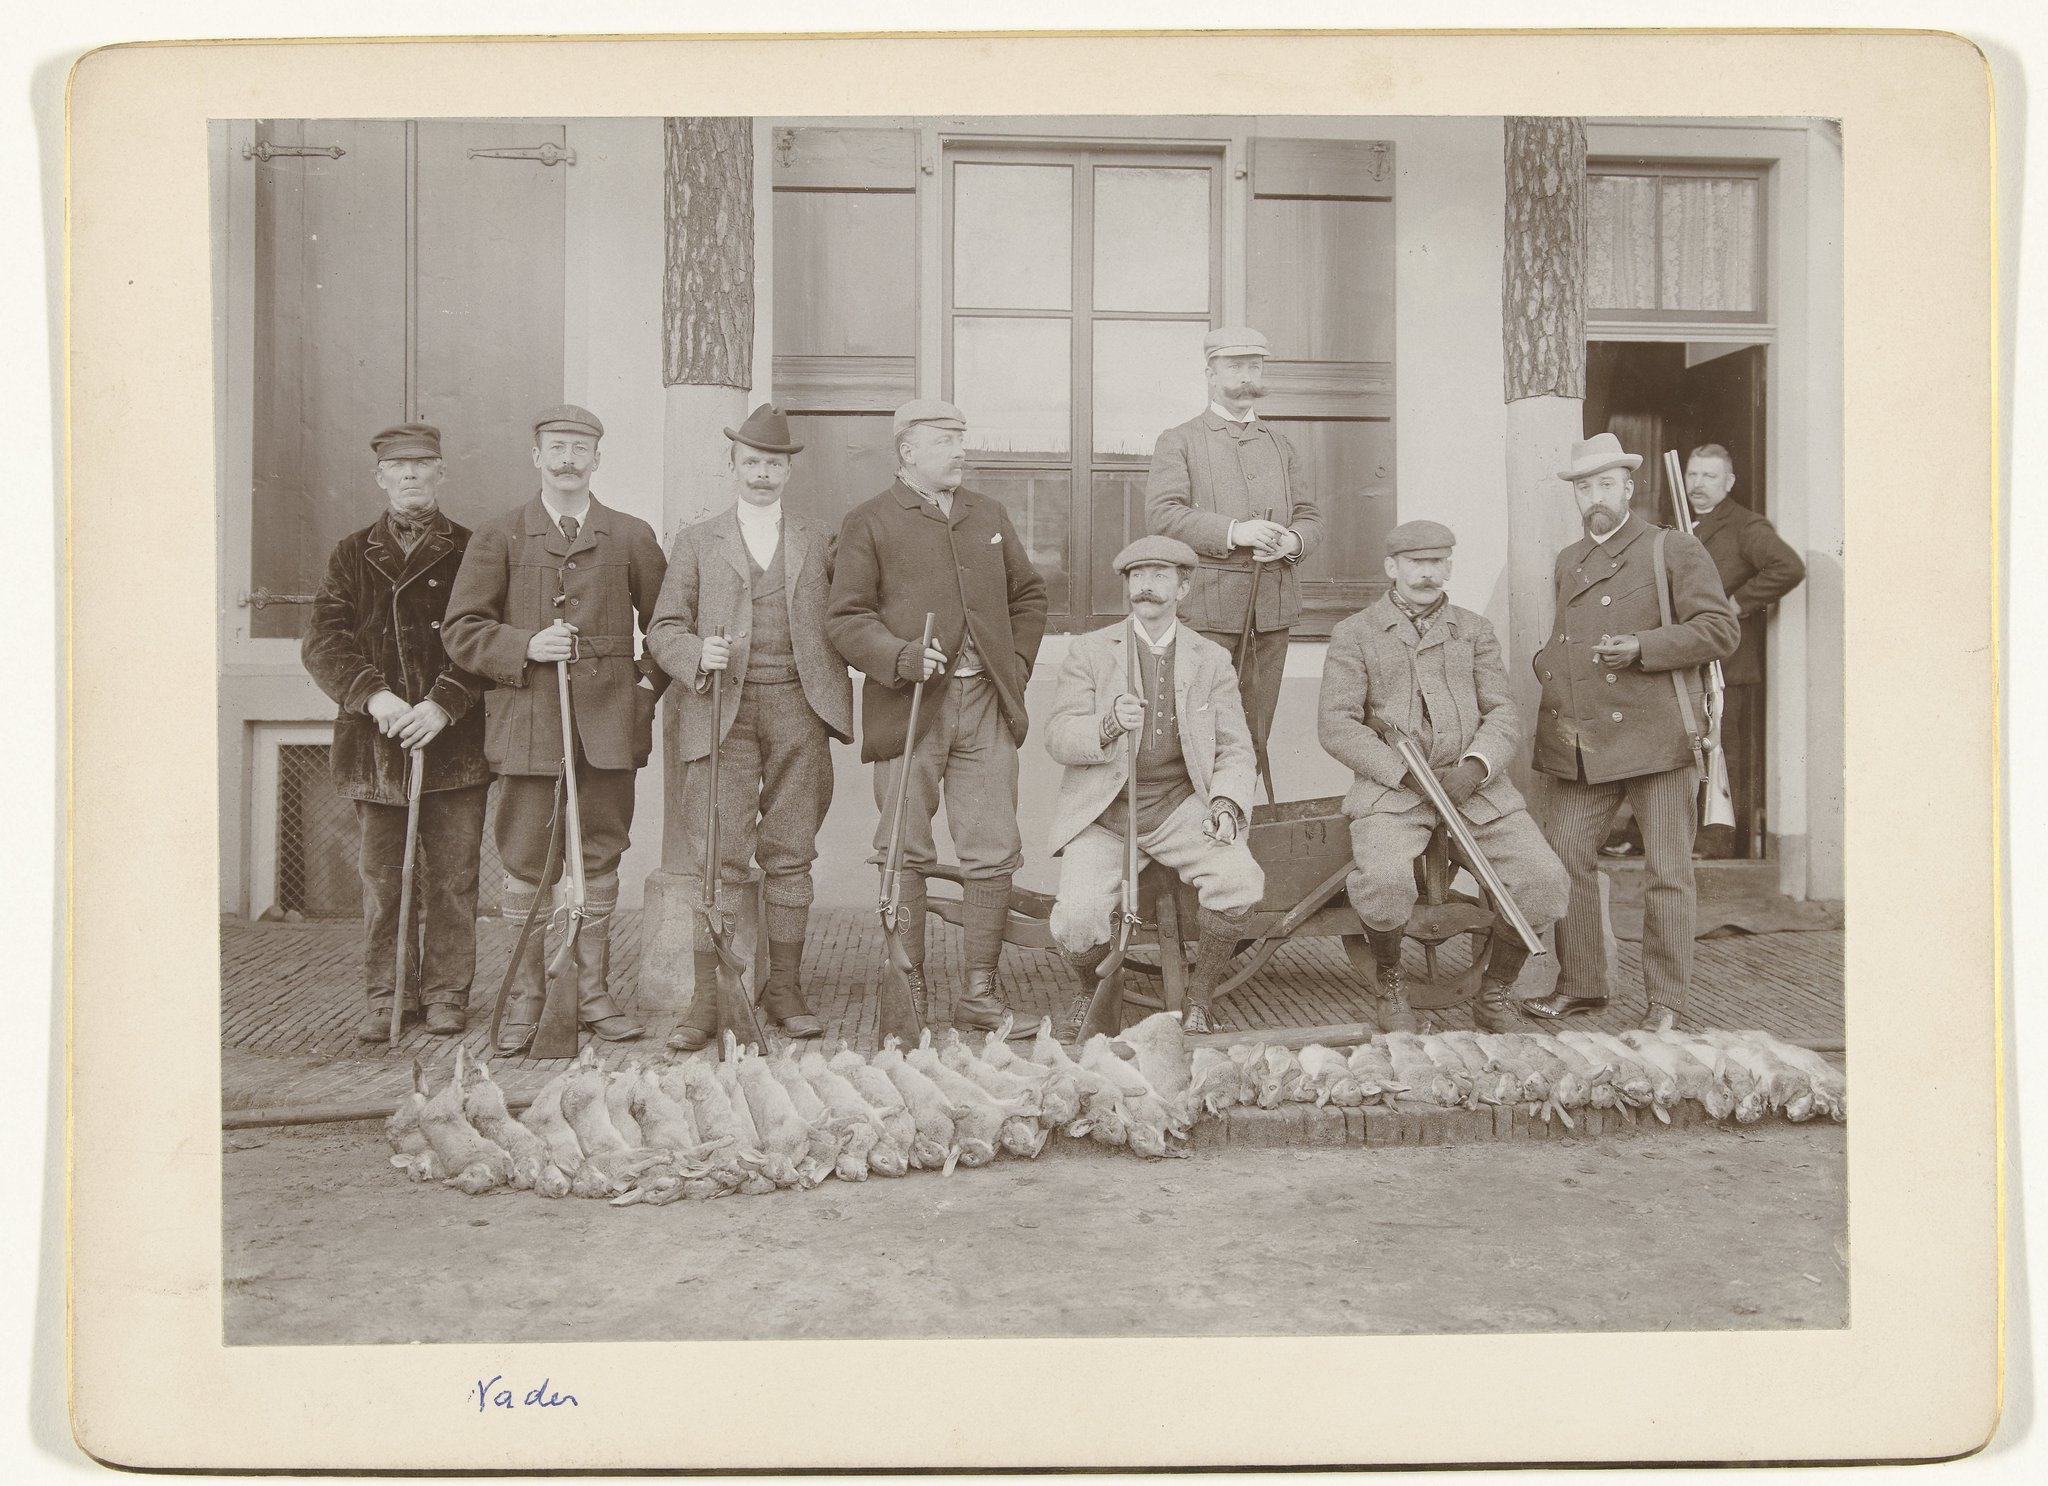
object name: photograph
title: Groepsportret van jagers en helpers, o.a. Henry Pauw van Wieldrecht en Maarten Pauw van Wieldrecht, met het geschoten wild aan hun voeten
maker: henry pauw van wieldrecht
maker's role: fotograaf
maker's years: 1863-1912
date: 1896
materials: cardboard, photographic support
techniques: gelatin silver print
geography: netherlands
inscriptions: annotation: ‘No. 1290. - 1896.’, annotation: ‘Vader’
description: Tweede van links Henry, zittend op de kruiwagen Maarten (rechts? links?)